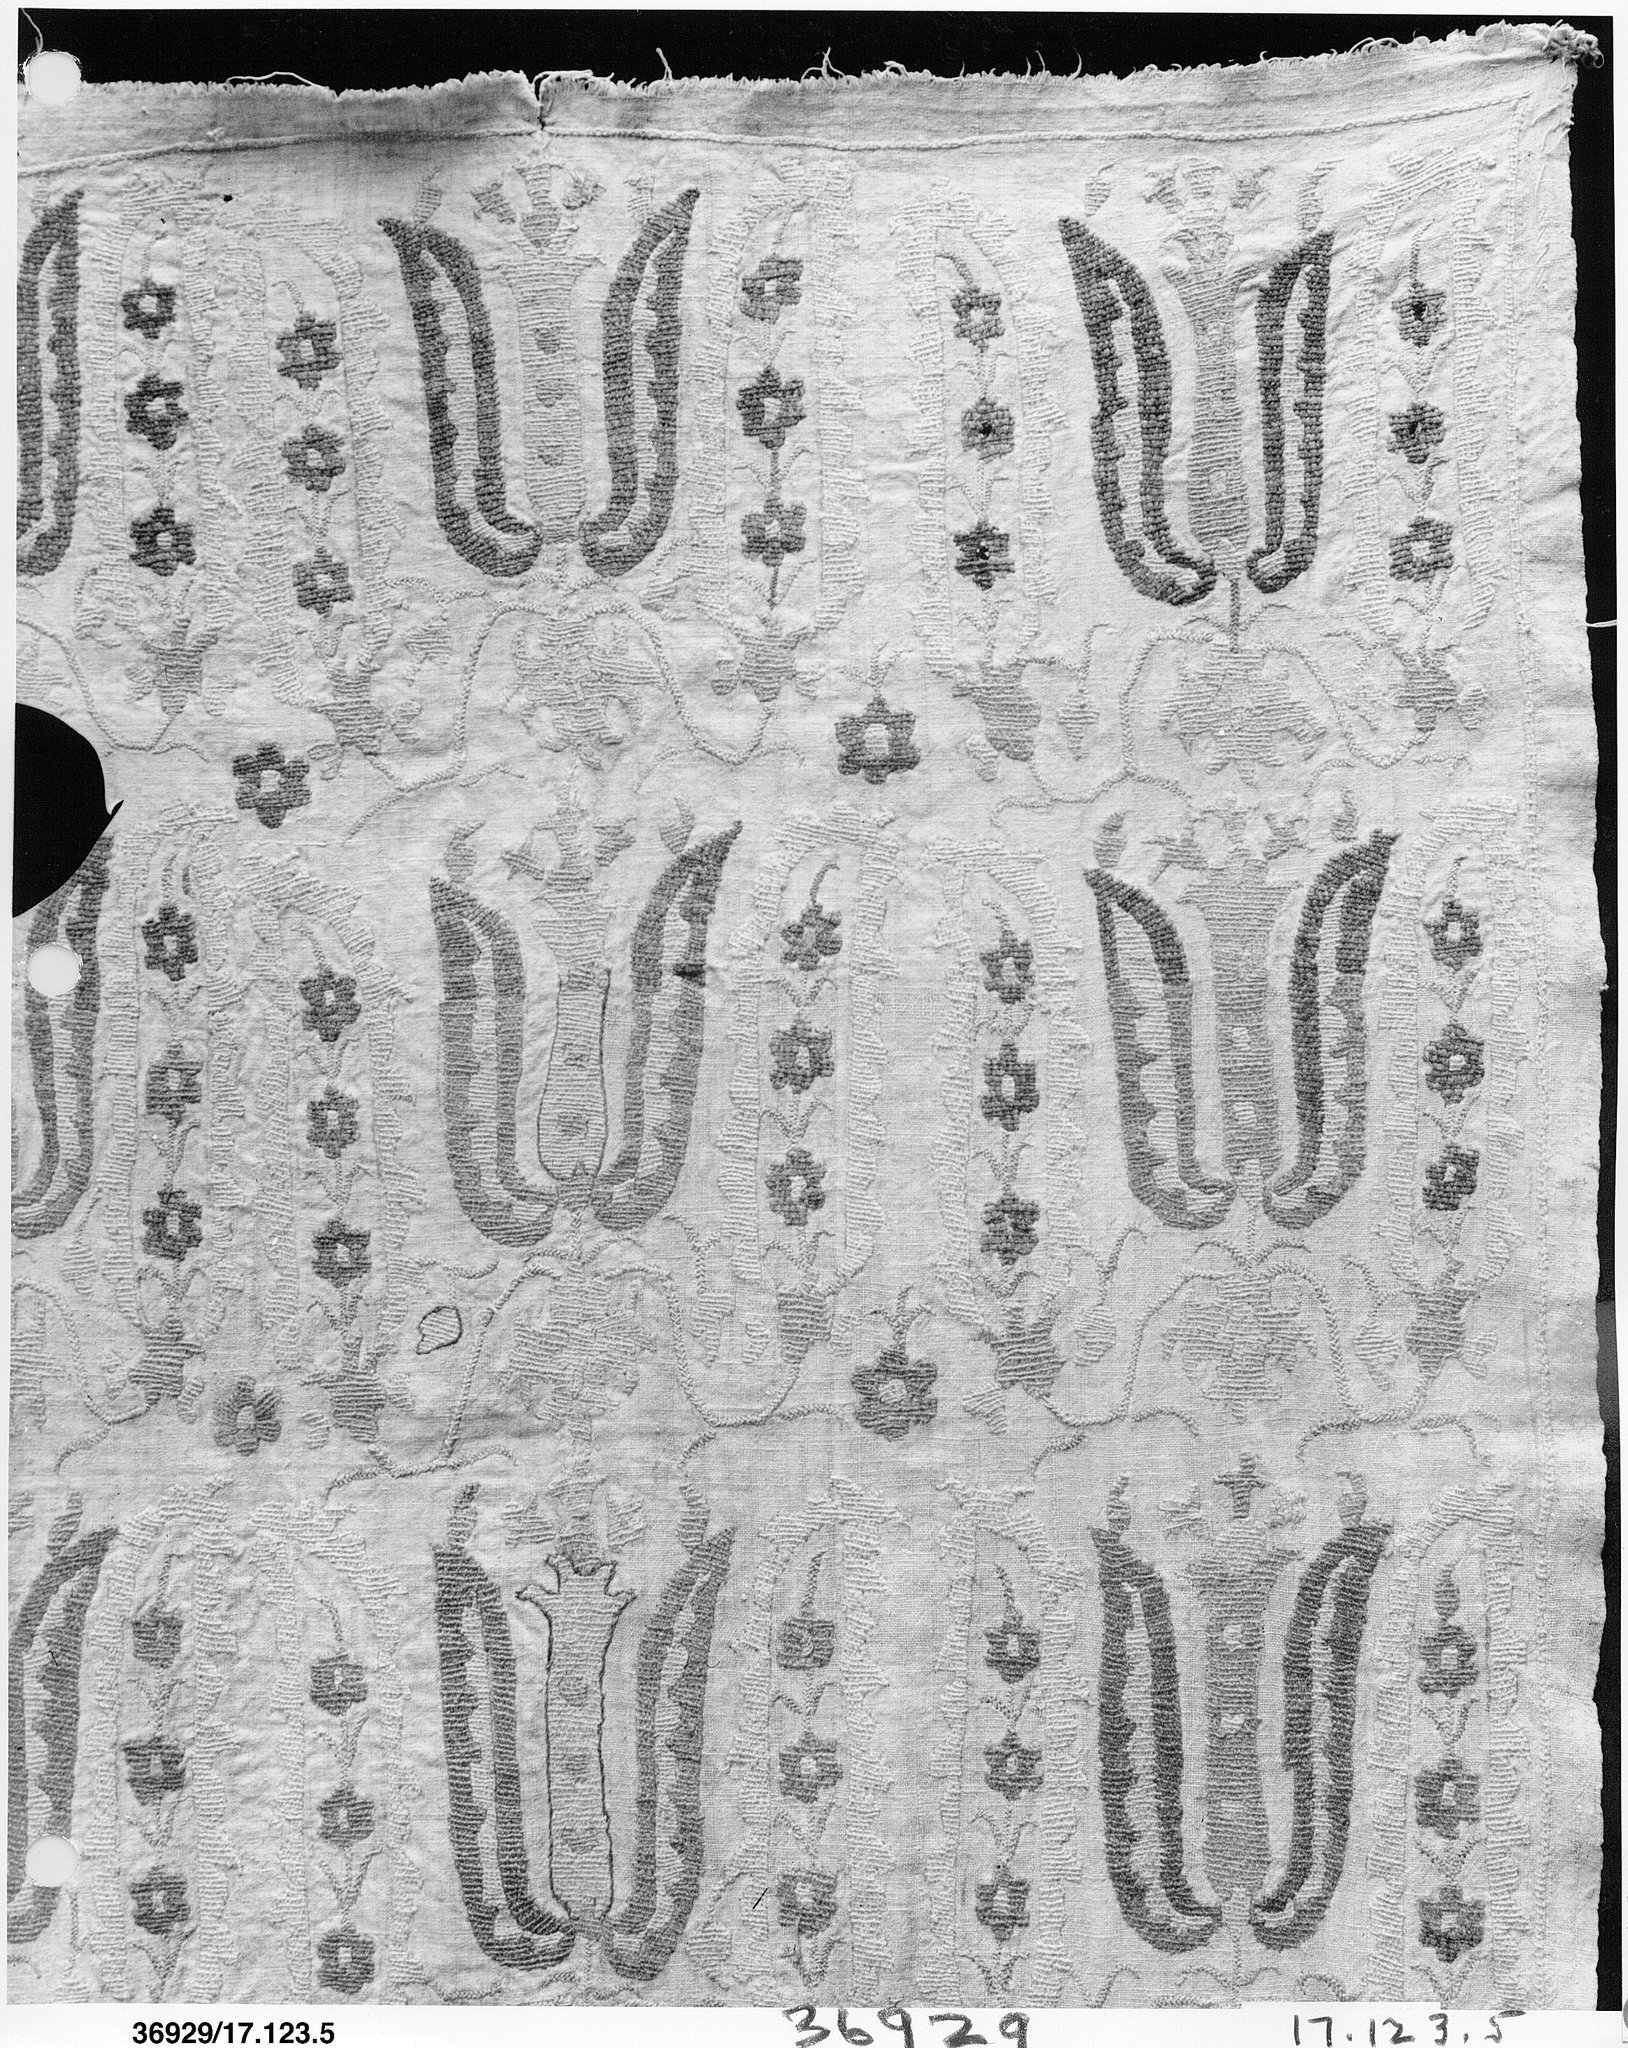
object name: textile fragment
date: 1701-1800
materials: cotton, silk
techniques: embroidery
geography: uzbekistan